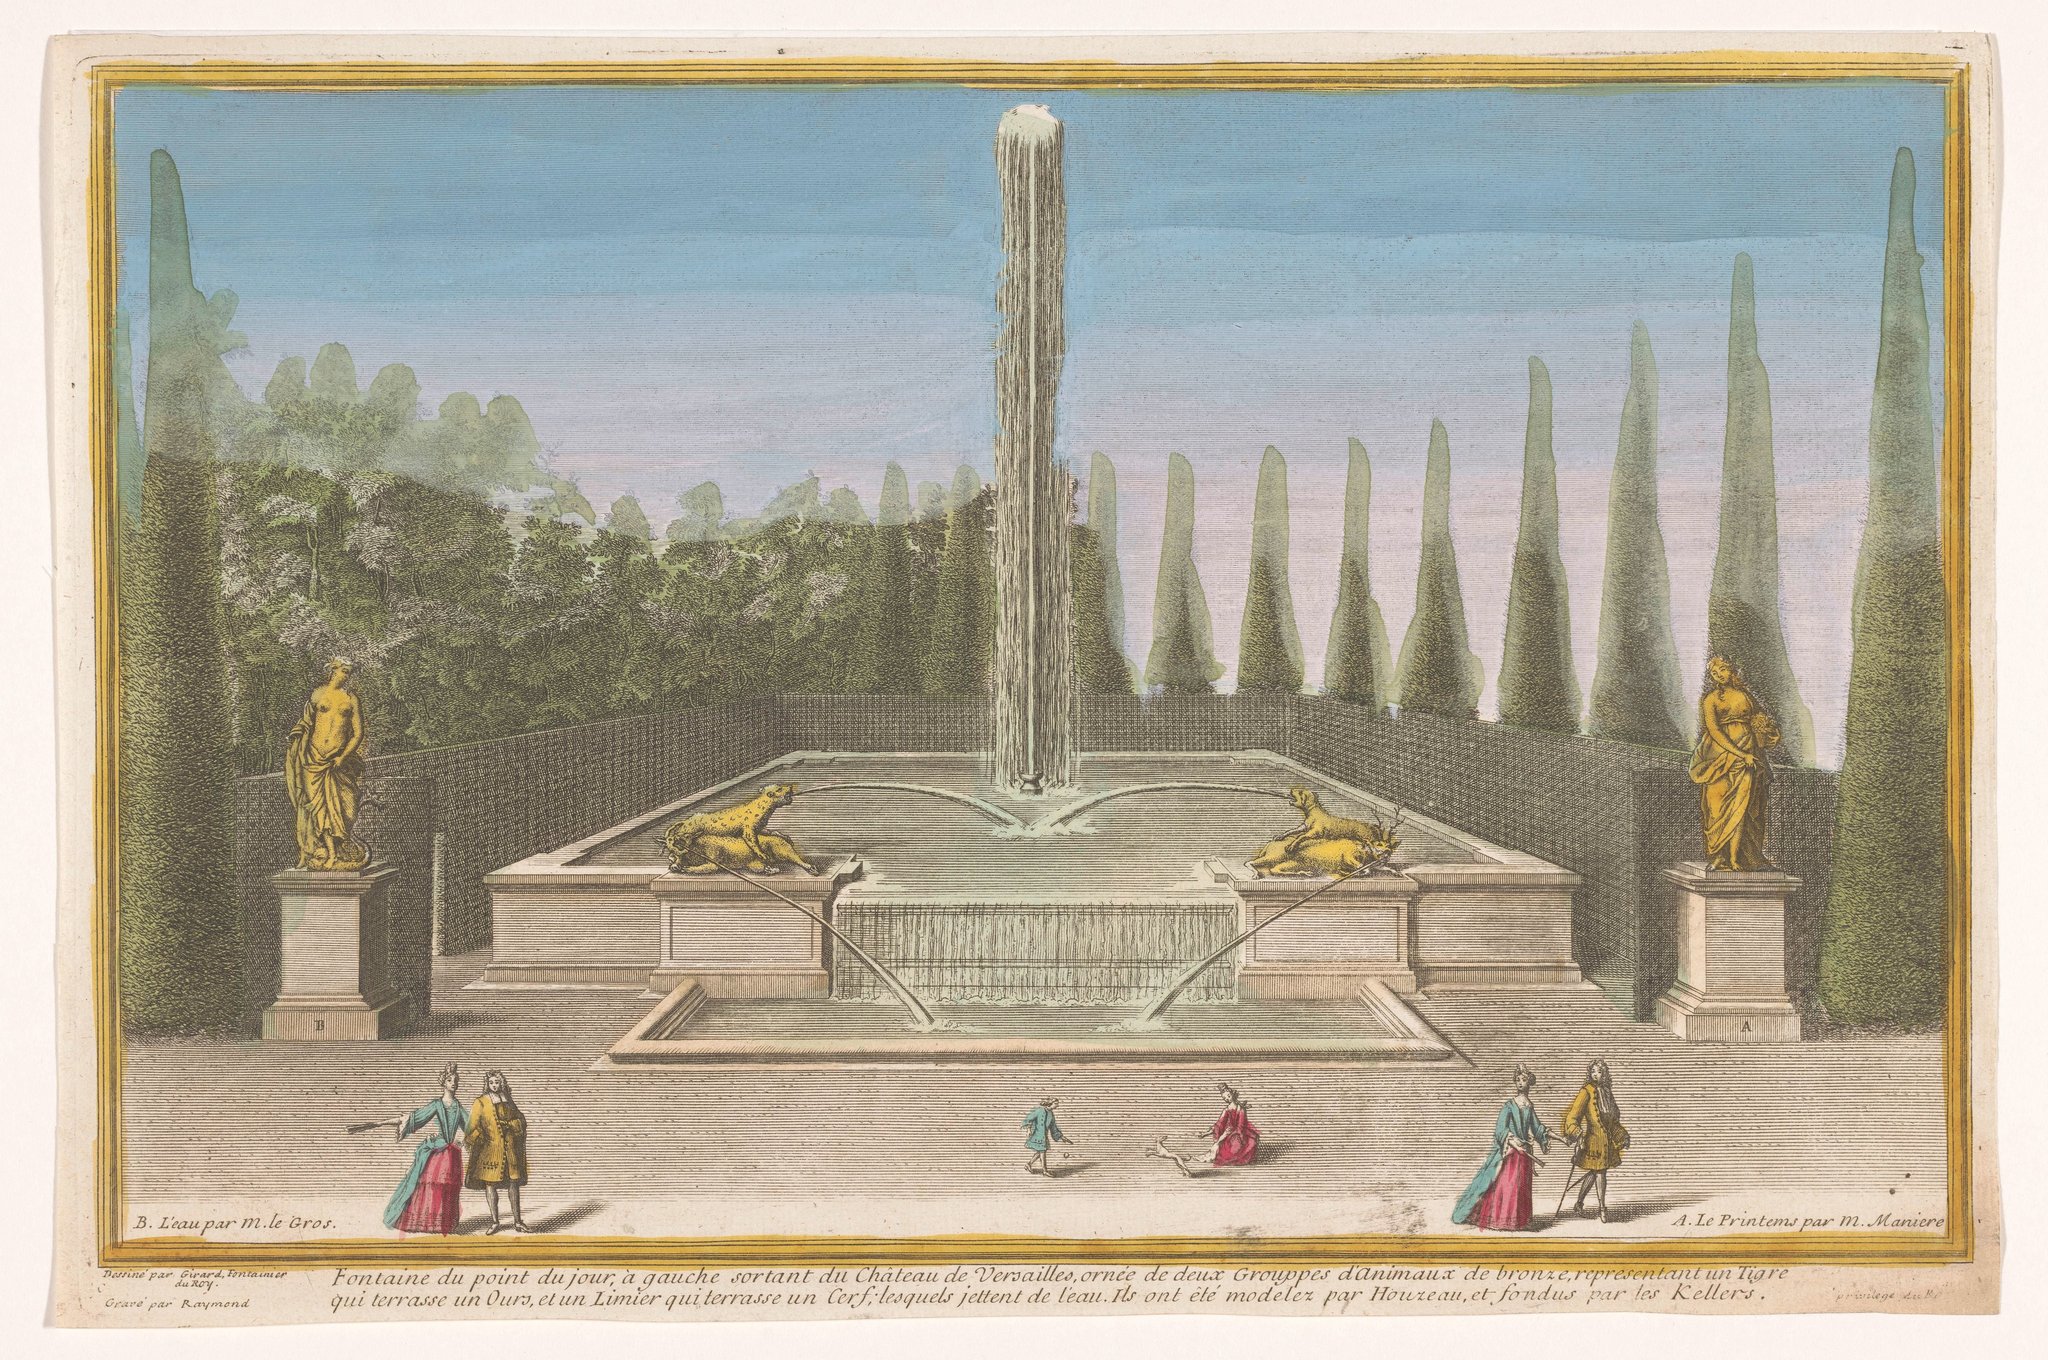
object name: print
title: Fontaine du Point du Jour, à gauche sortant du Château de Versailles (...)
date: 1700-1799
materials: paper, watercolor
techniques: brush, etching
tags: garden, garden fountain, ornamental plants, garden ornaments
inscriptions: collector's mark: Lugt 2233, watermark